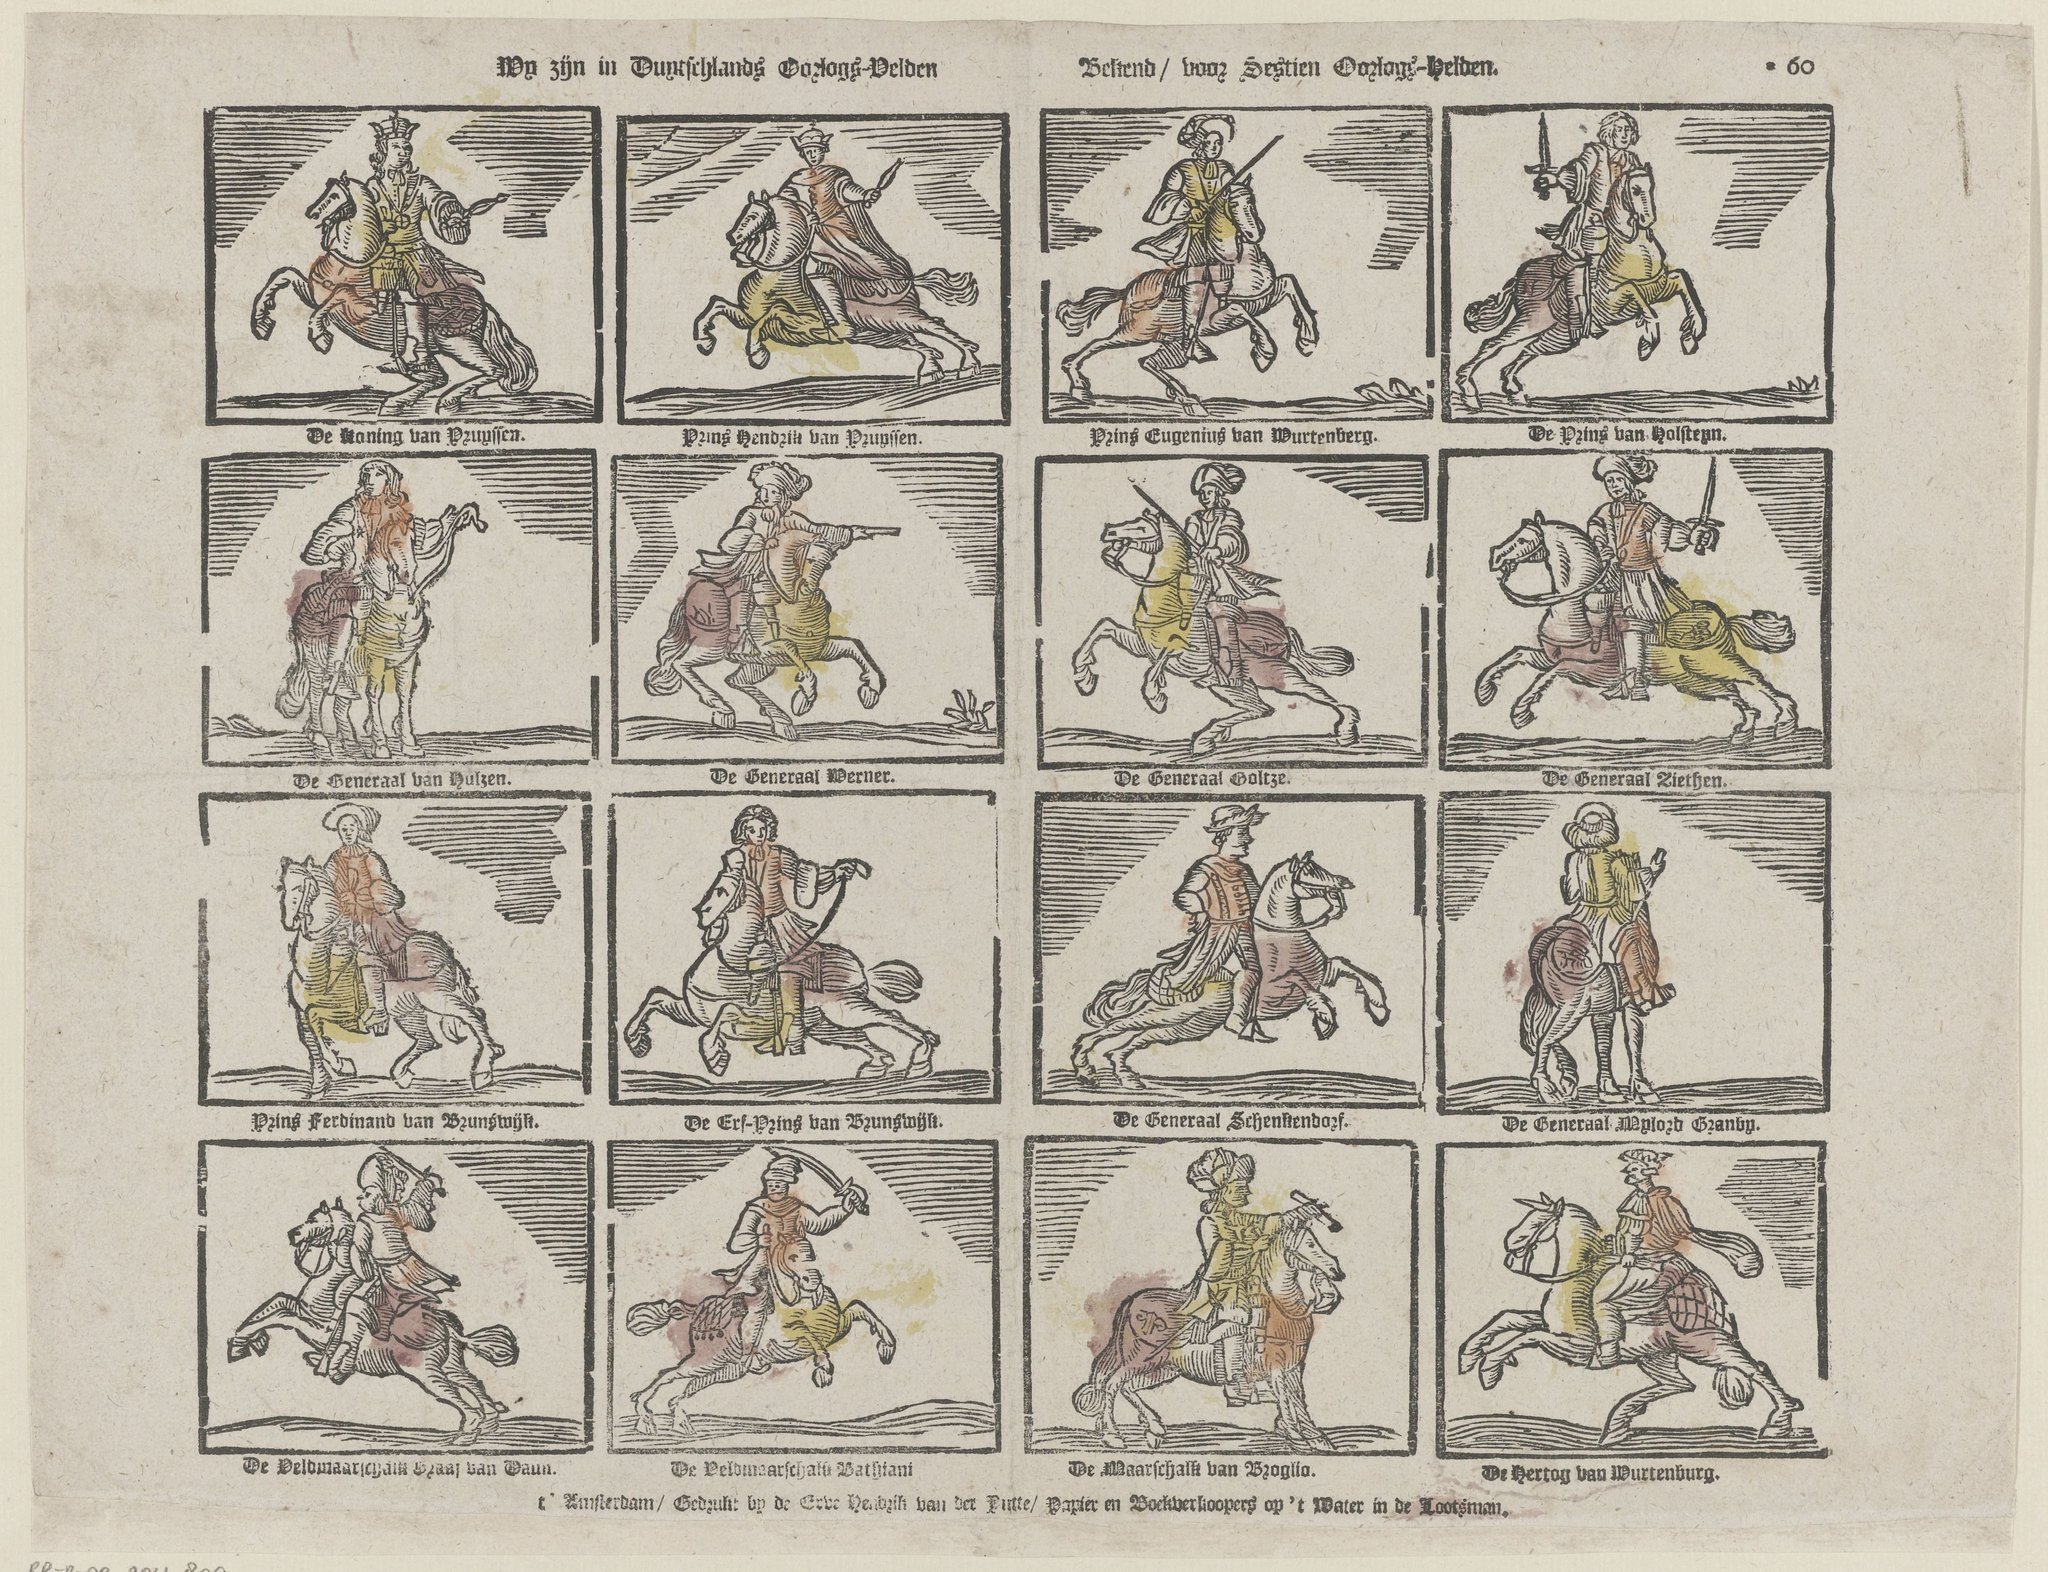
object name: popular print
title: Wy zijn in Duytschlands oorlogs-velden / bekend / voor sestien oorlogs-helden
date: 1767-1793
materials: paper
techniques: colour, letterpress printing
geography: amsterdam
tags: berlin, friedrich heinrich ludwig van pruisen, frederik willem i koning van pruisen, equestrian state-portrait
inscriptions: collector's mark: Lugt 2760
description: Blad met 16 voorstellingen van vorsten en generaals te paard, onder wie Frederik Hendrik Lodewijk (prins van Pruisen) en Frederik Willem I (koning van Pruisen). Onder elke afbeelding een onderschrift. Genummerd rechtsboven: *60.